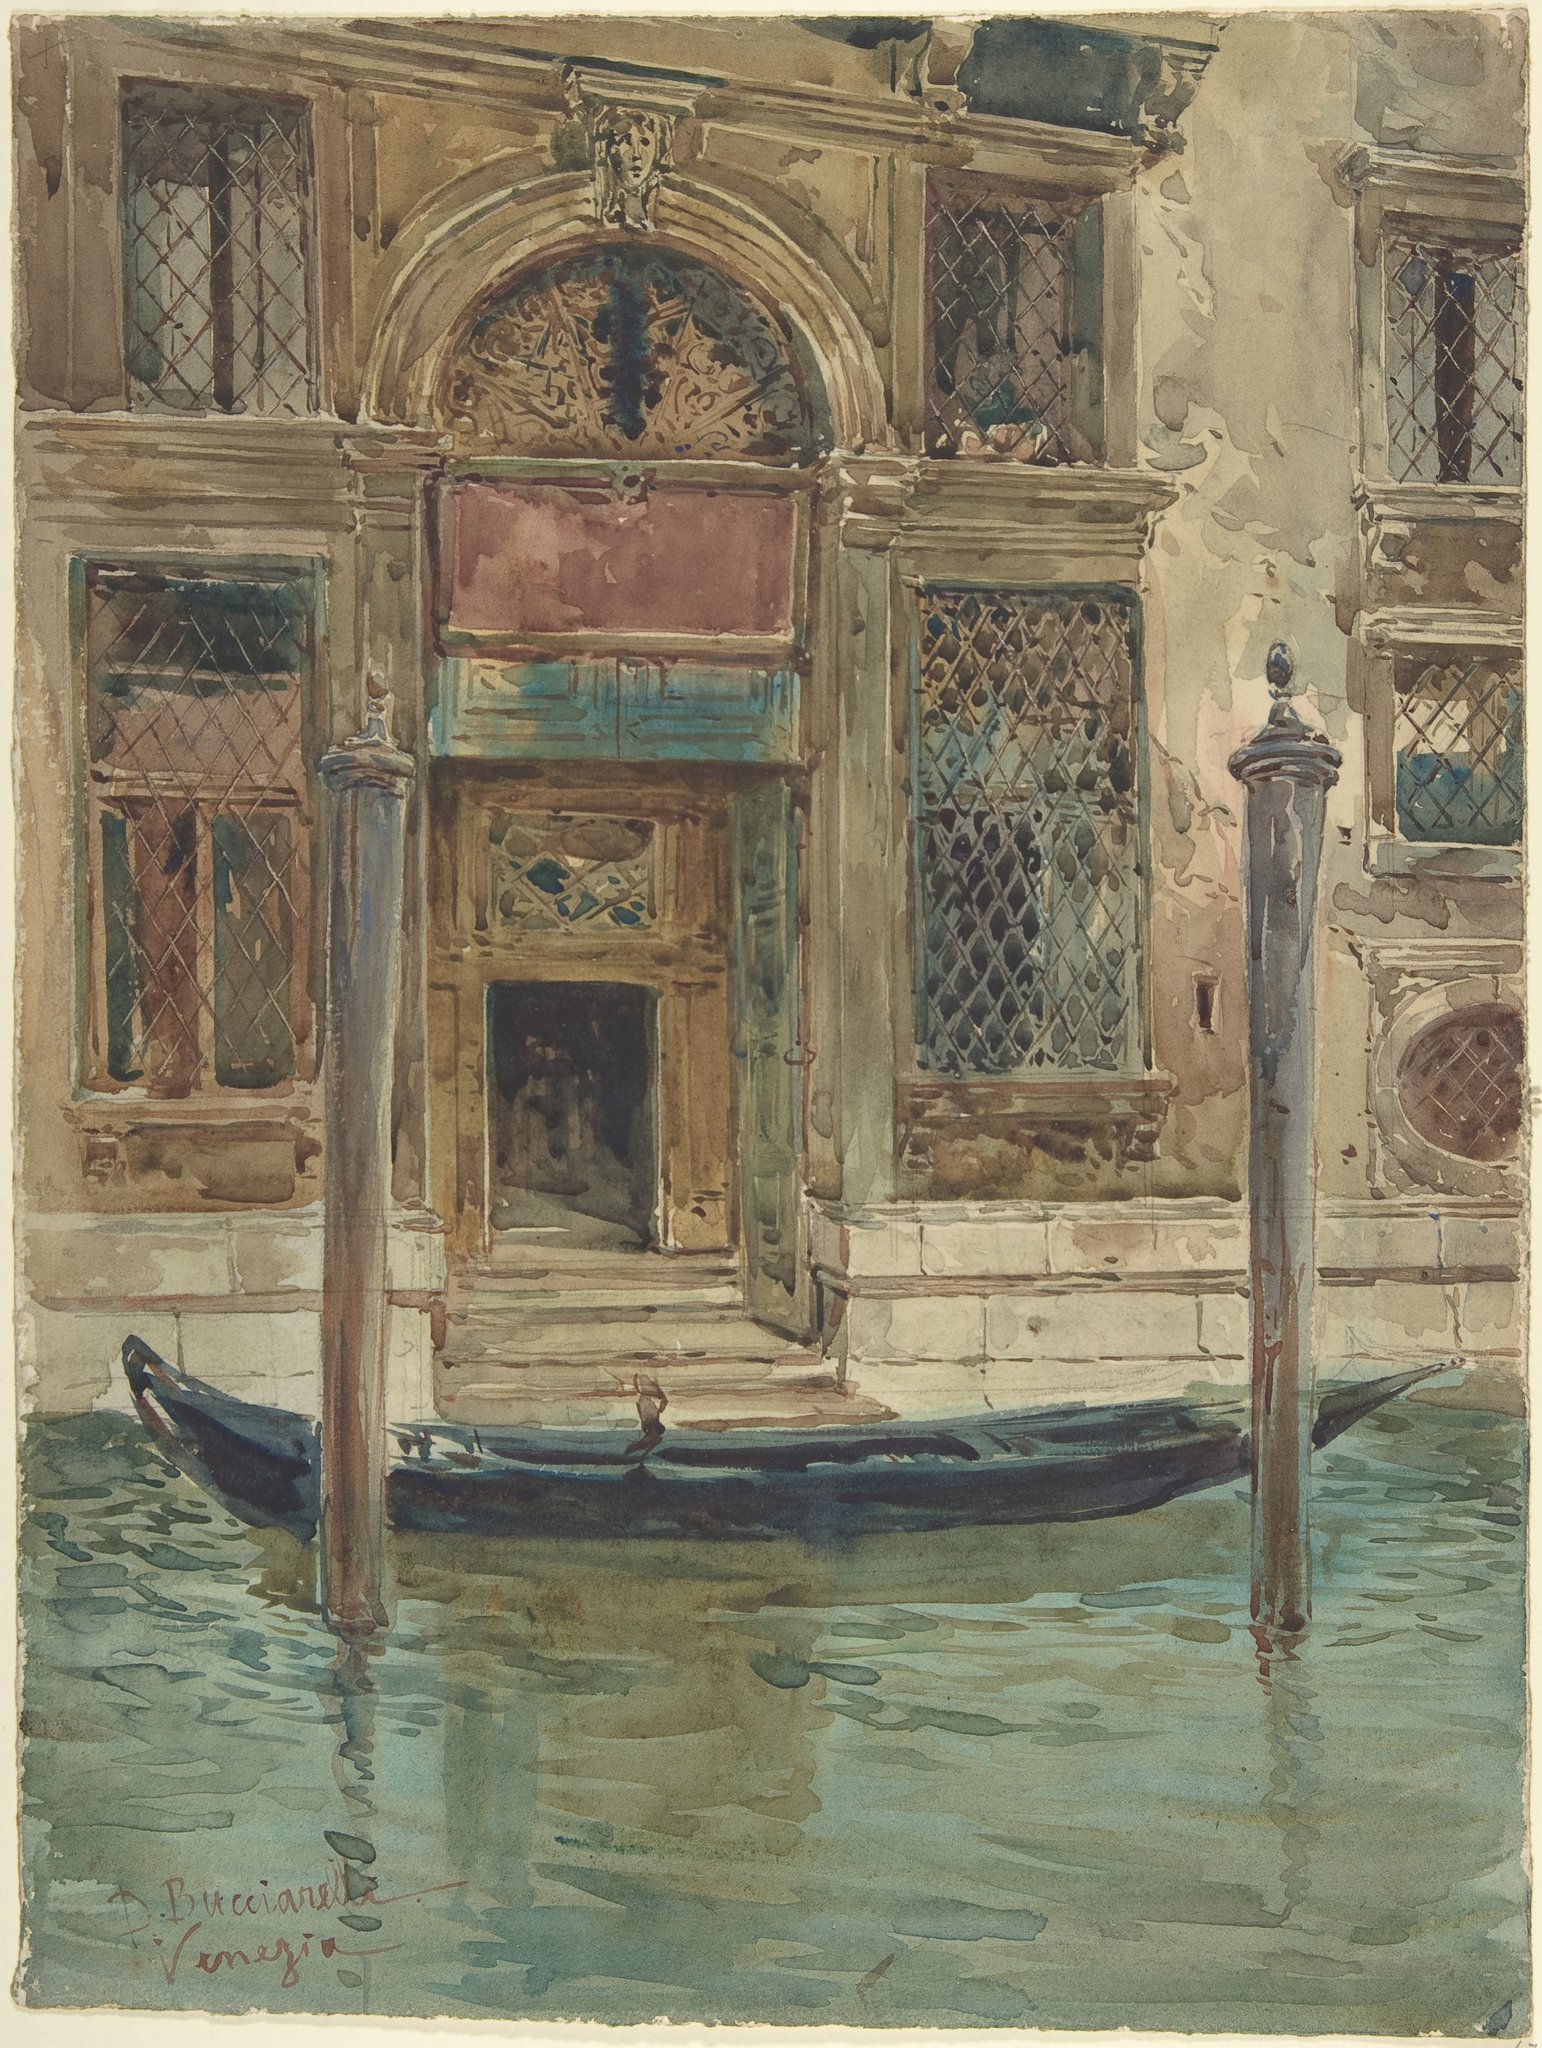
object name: drawing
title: Portal of a Venetian Palace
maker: daniele bucciarelli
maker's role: artist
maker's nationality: italian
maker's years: 1839-1911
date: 1839-1911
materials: watercolor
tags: palaces,boats,venice